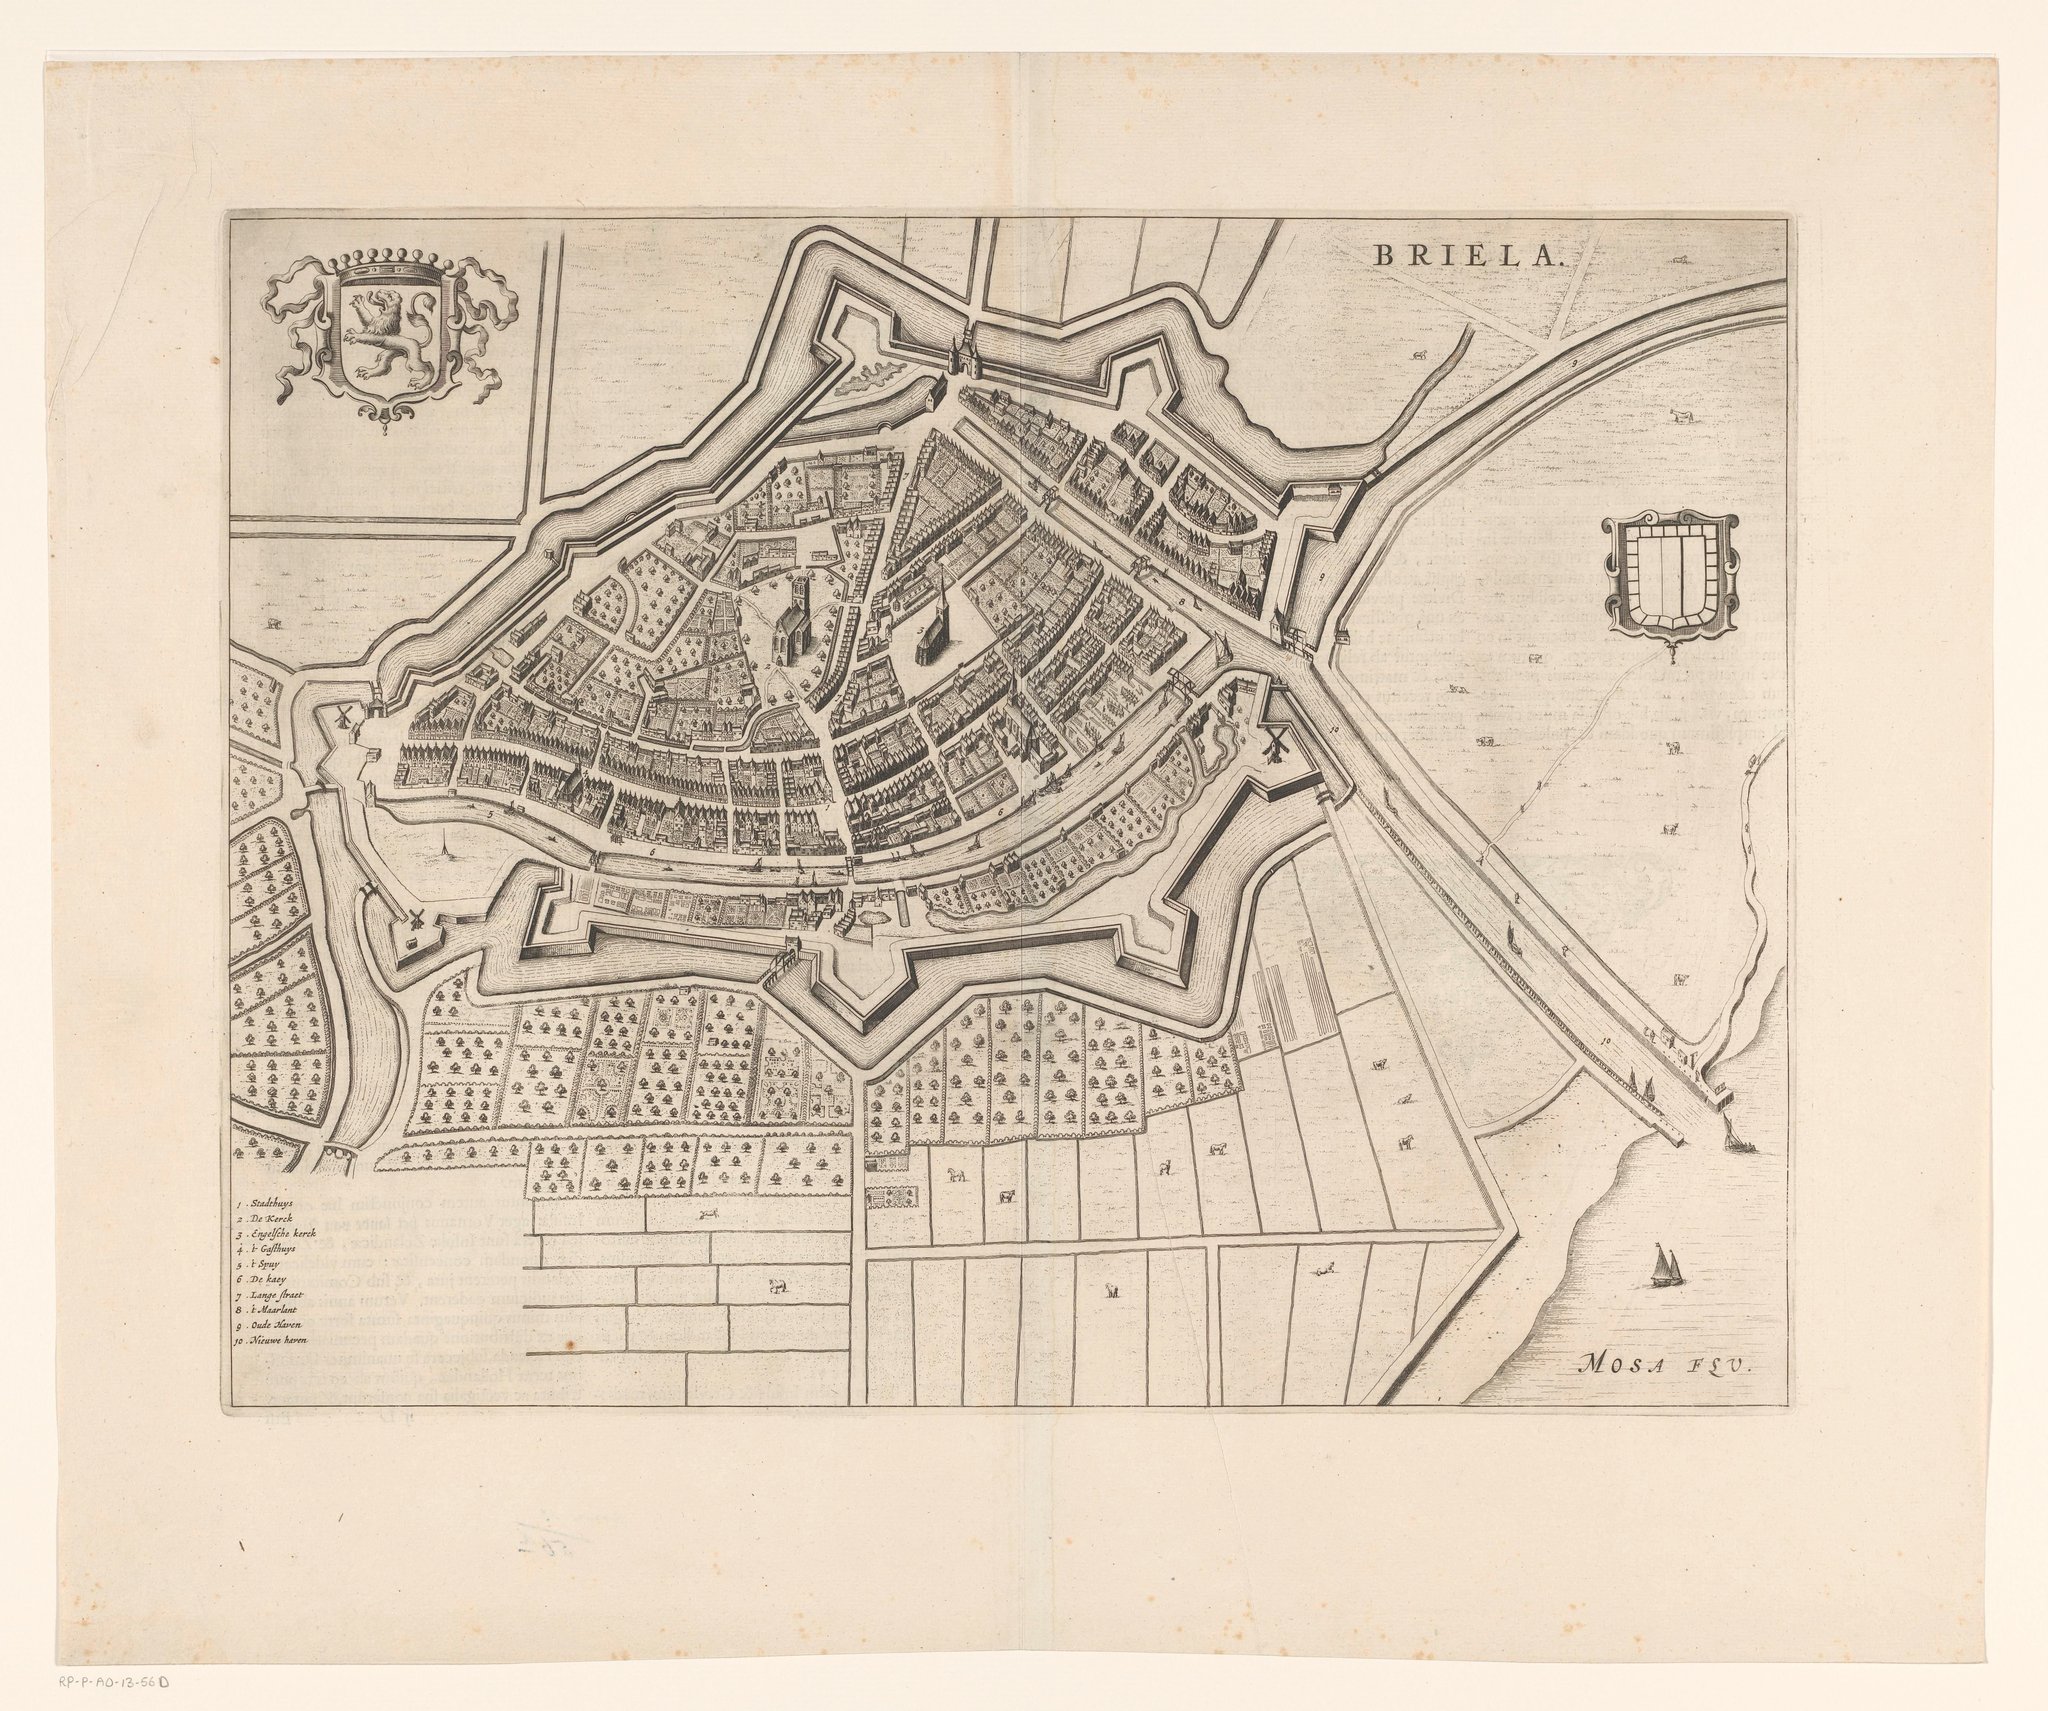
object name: area plan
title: Briela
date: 1652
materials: paper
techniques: engraving, etching, letterpress printing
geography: amsterdam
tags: coat of arms (as symbol of the state, etc.) (+ city; municipal), maps of cities, coat of arms (as symbol of the state, etc.) (+ province; provincial), brielle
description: Plattegrond in vogelvluchtperspectief. Linksboven het wapen van Holland, rechtsboven dat van Brielle. Linksonder een legenda 1-10. Op verso Latijnse tekst. Oriëntatie: noorden rechts.